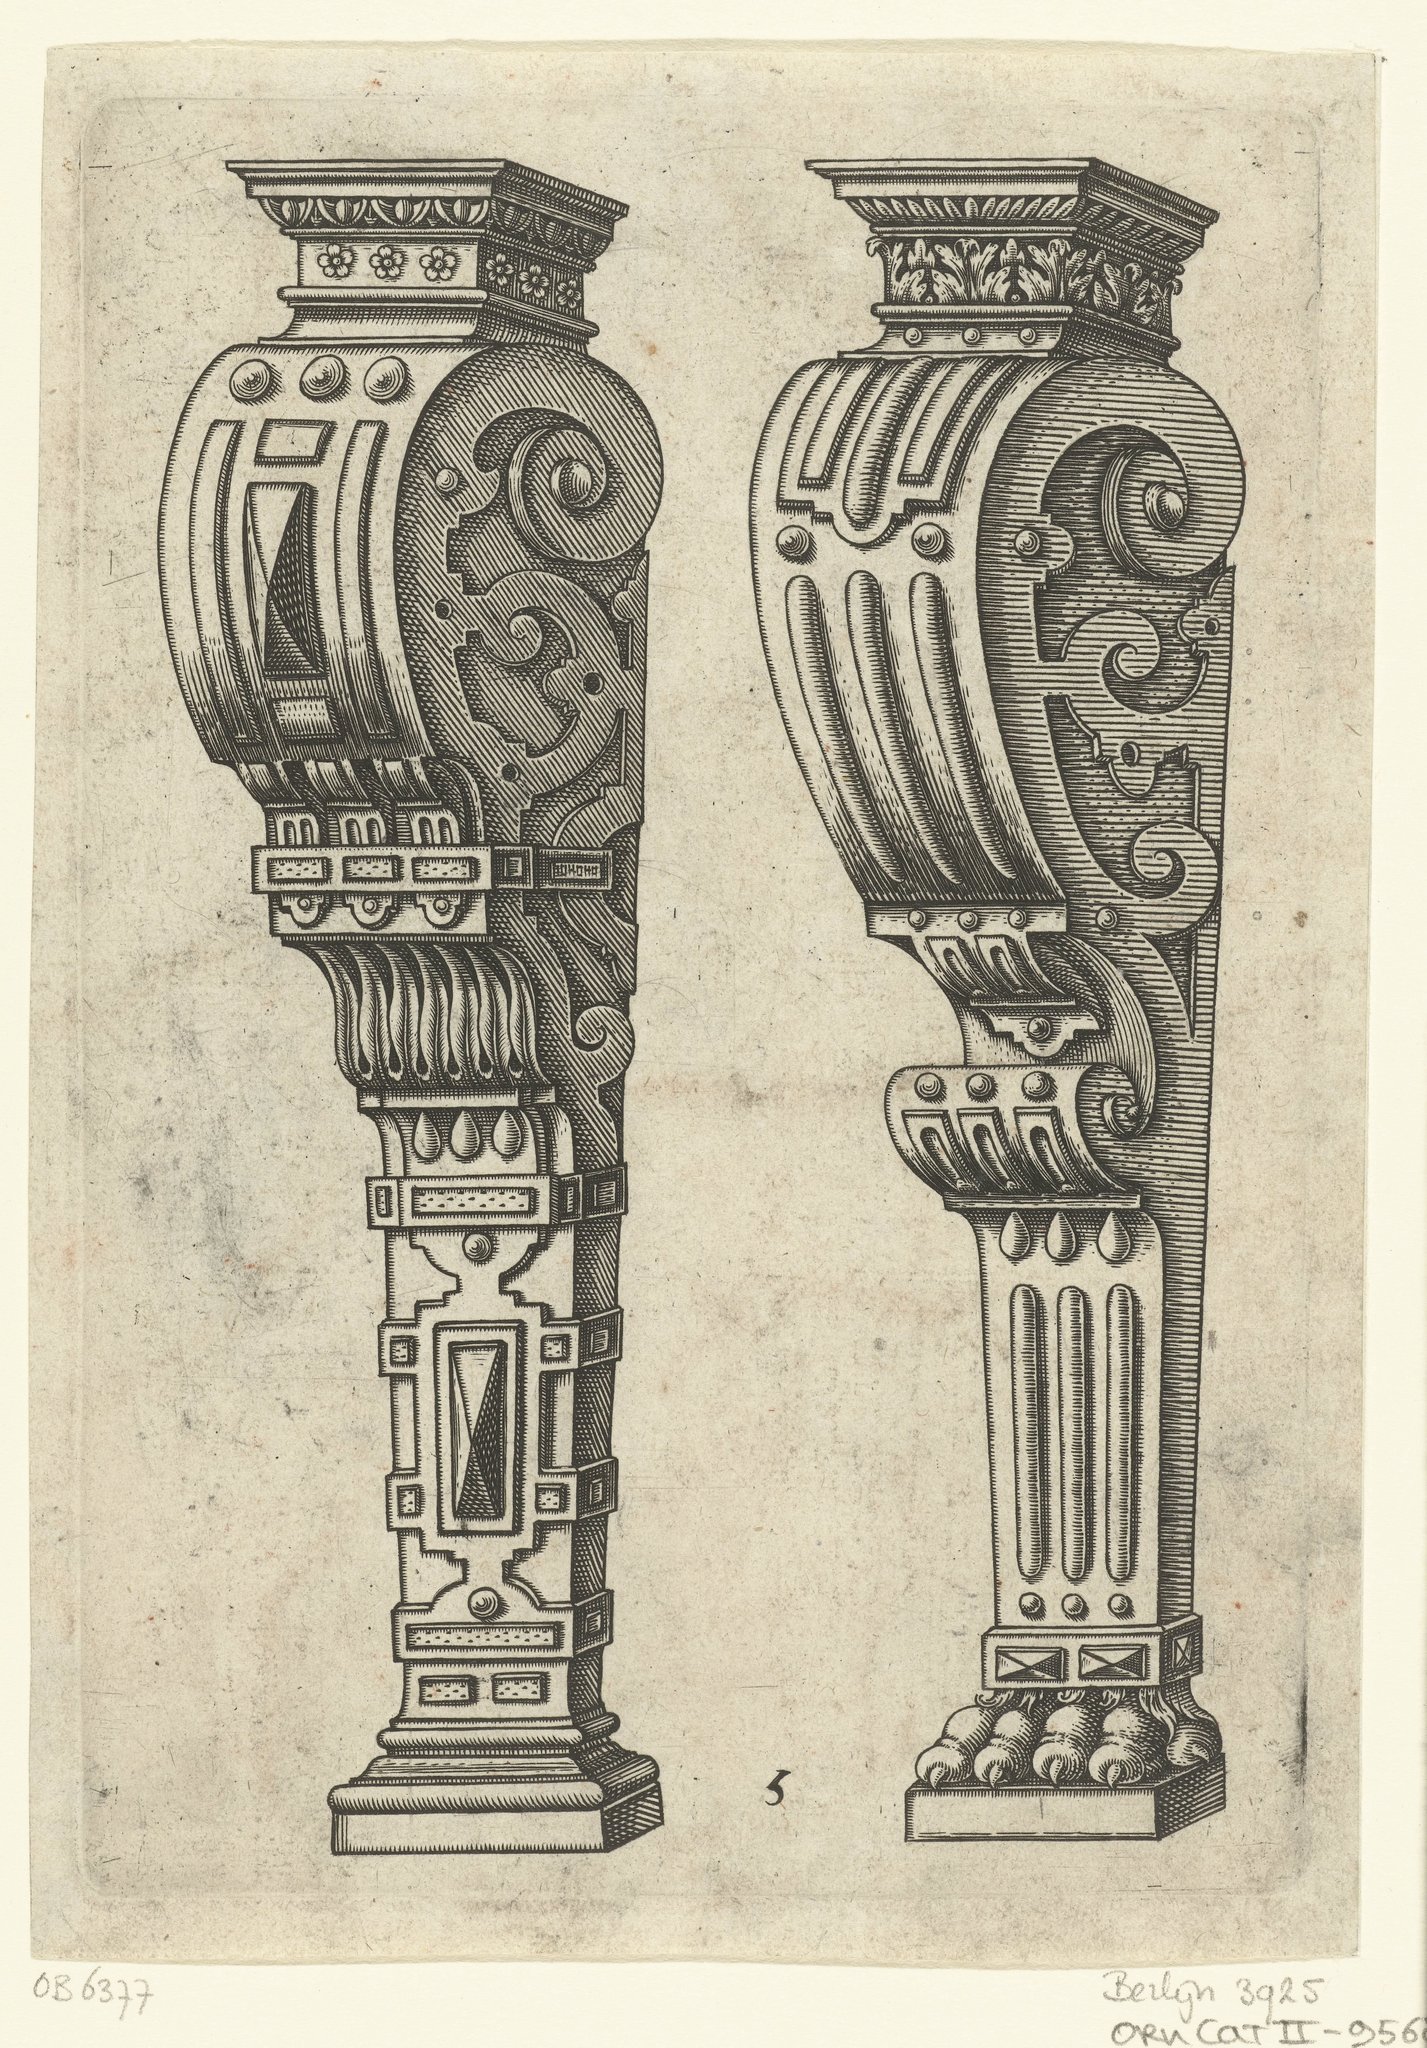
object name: print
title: Etliche zierliche und underscheidliche termen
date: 1604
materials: paper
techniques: engraving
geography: amsterdam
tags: tuscan order ~ architecture